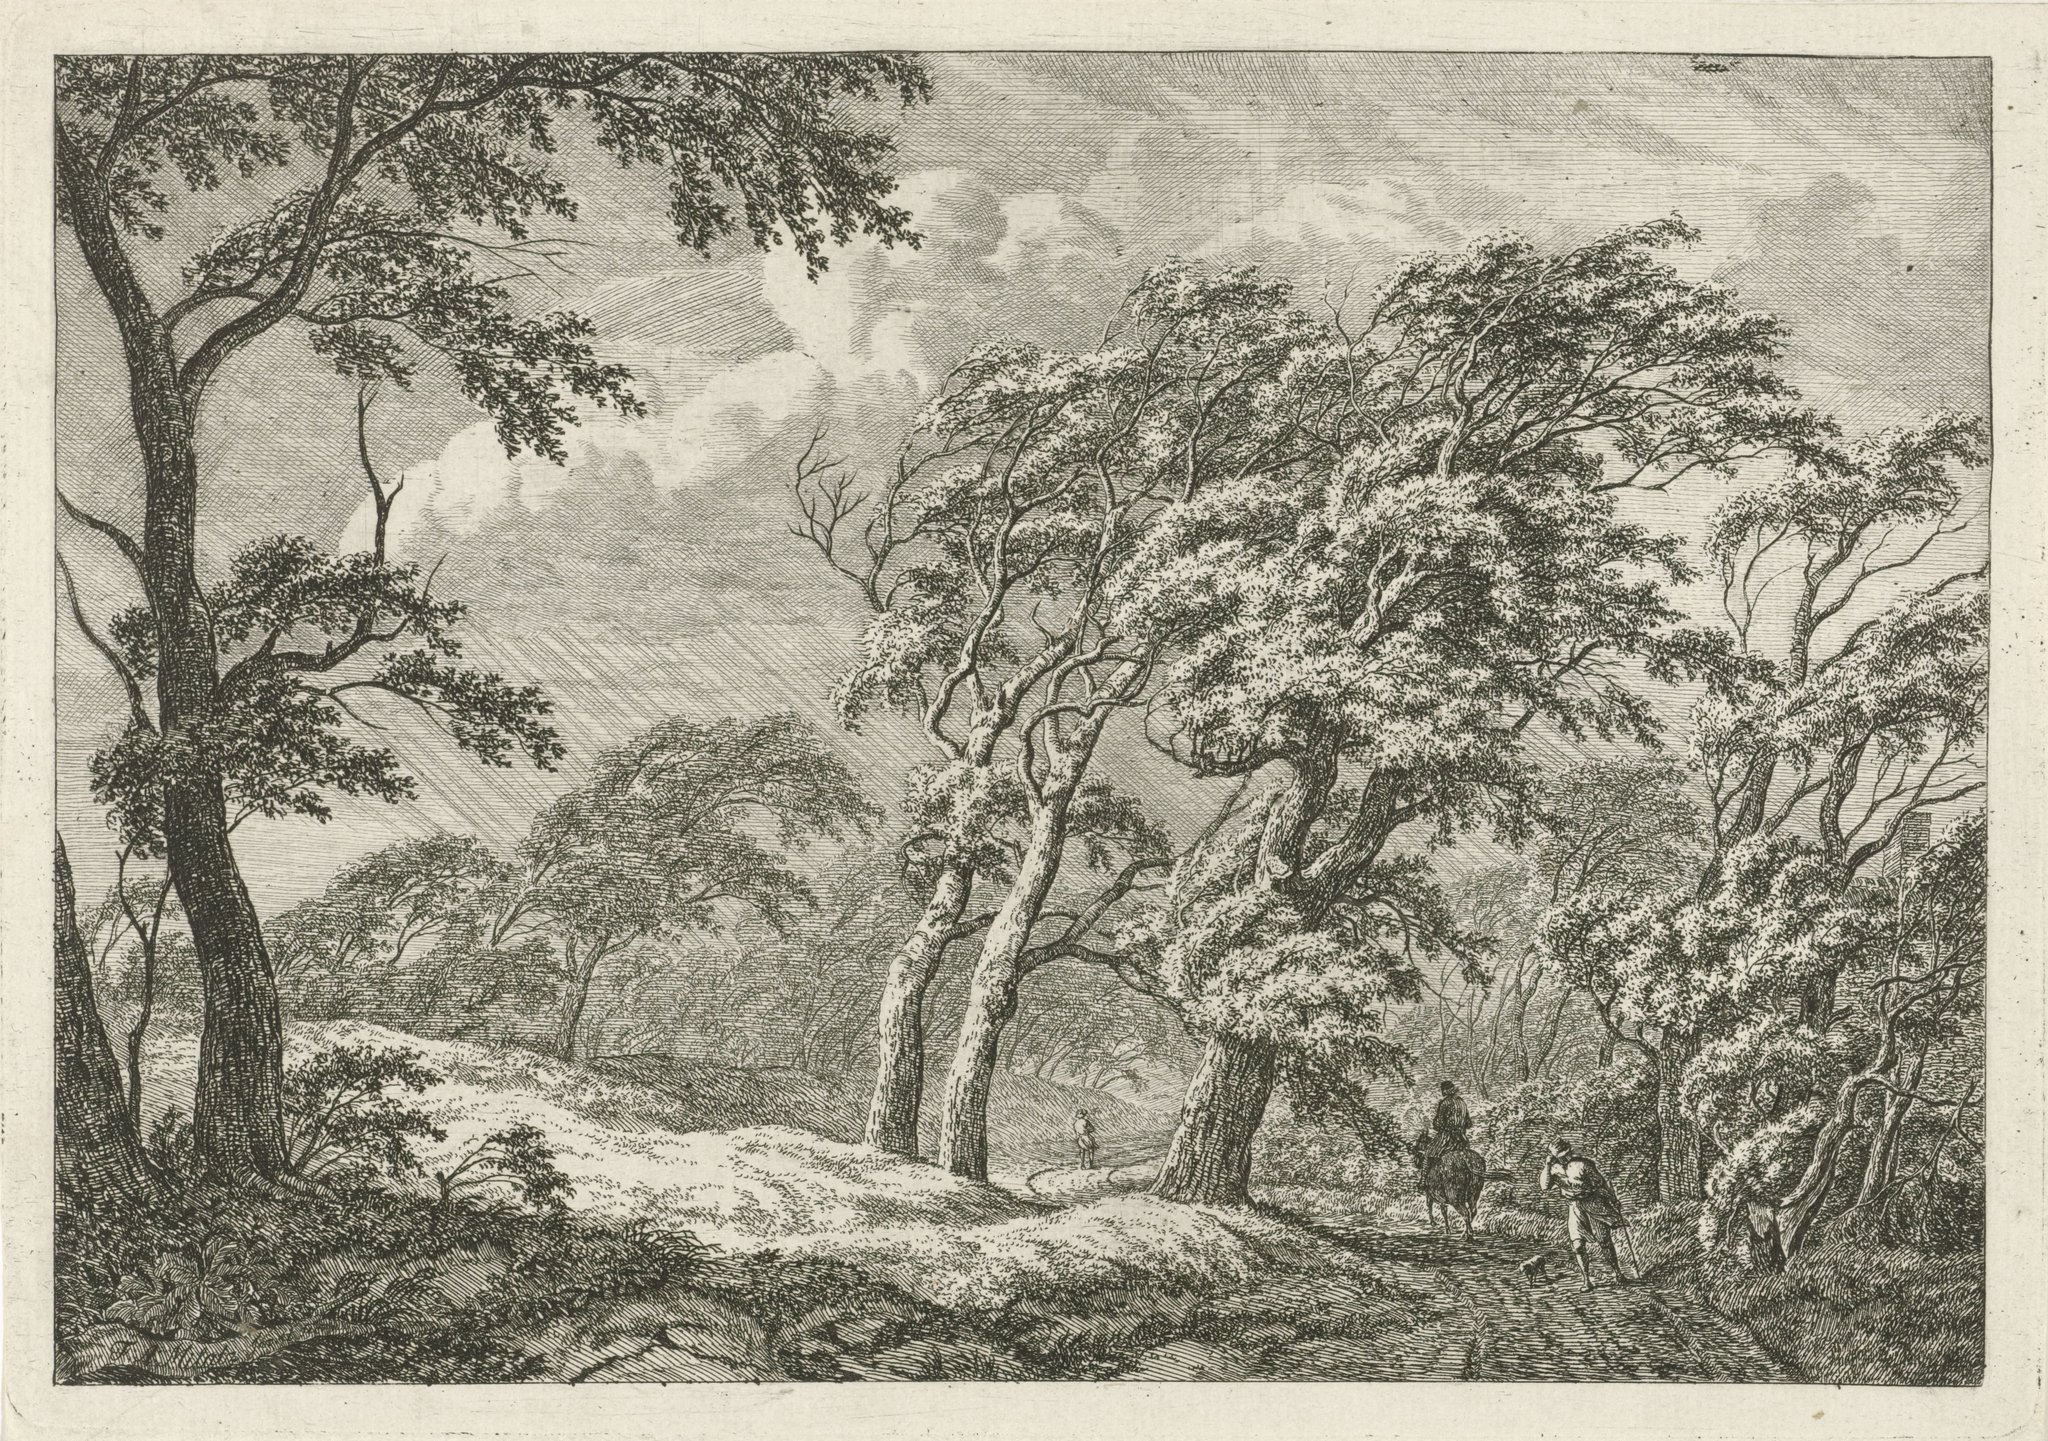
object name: print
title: Landschap met storm en regen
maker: franciscus andreas milatz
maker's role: draughtsman, painter, print maker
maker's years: 1764-1808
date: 1784-1808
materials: paper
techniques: etching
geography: haarlem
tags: trees, rain, 'en route', traveller under way, storm on land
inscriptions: collector's mark: Lugt 2228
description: Een duinlandschap met door de storm gebogen bomen en regen. Rechts een ruiter en een man met een hond op de weg.